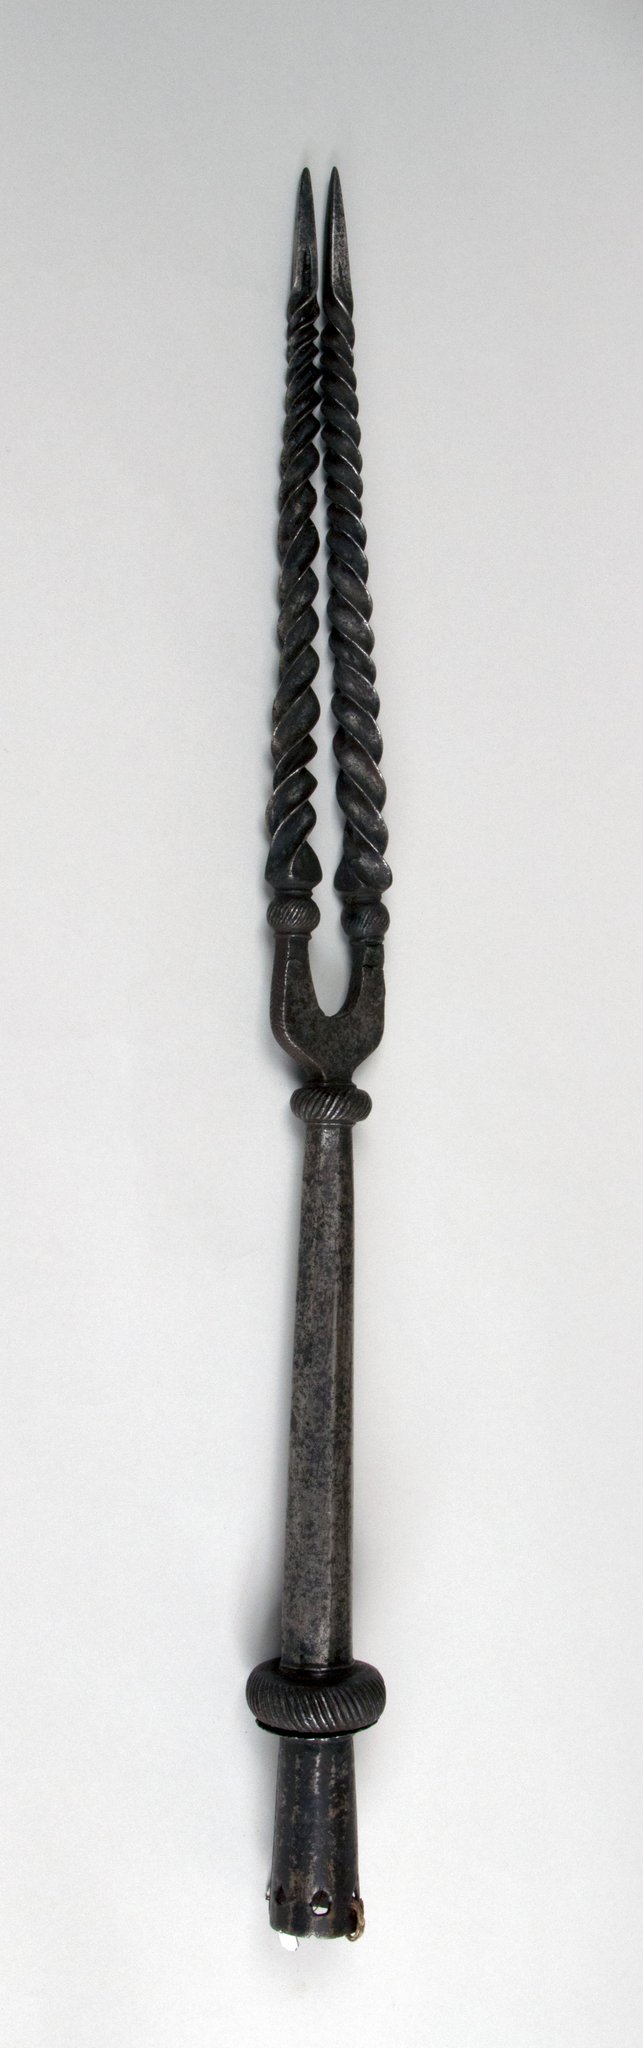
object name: spearhead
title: Bident Spearhead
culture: indian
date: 1701-1900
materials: steel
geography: india